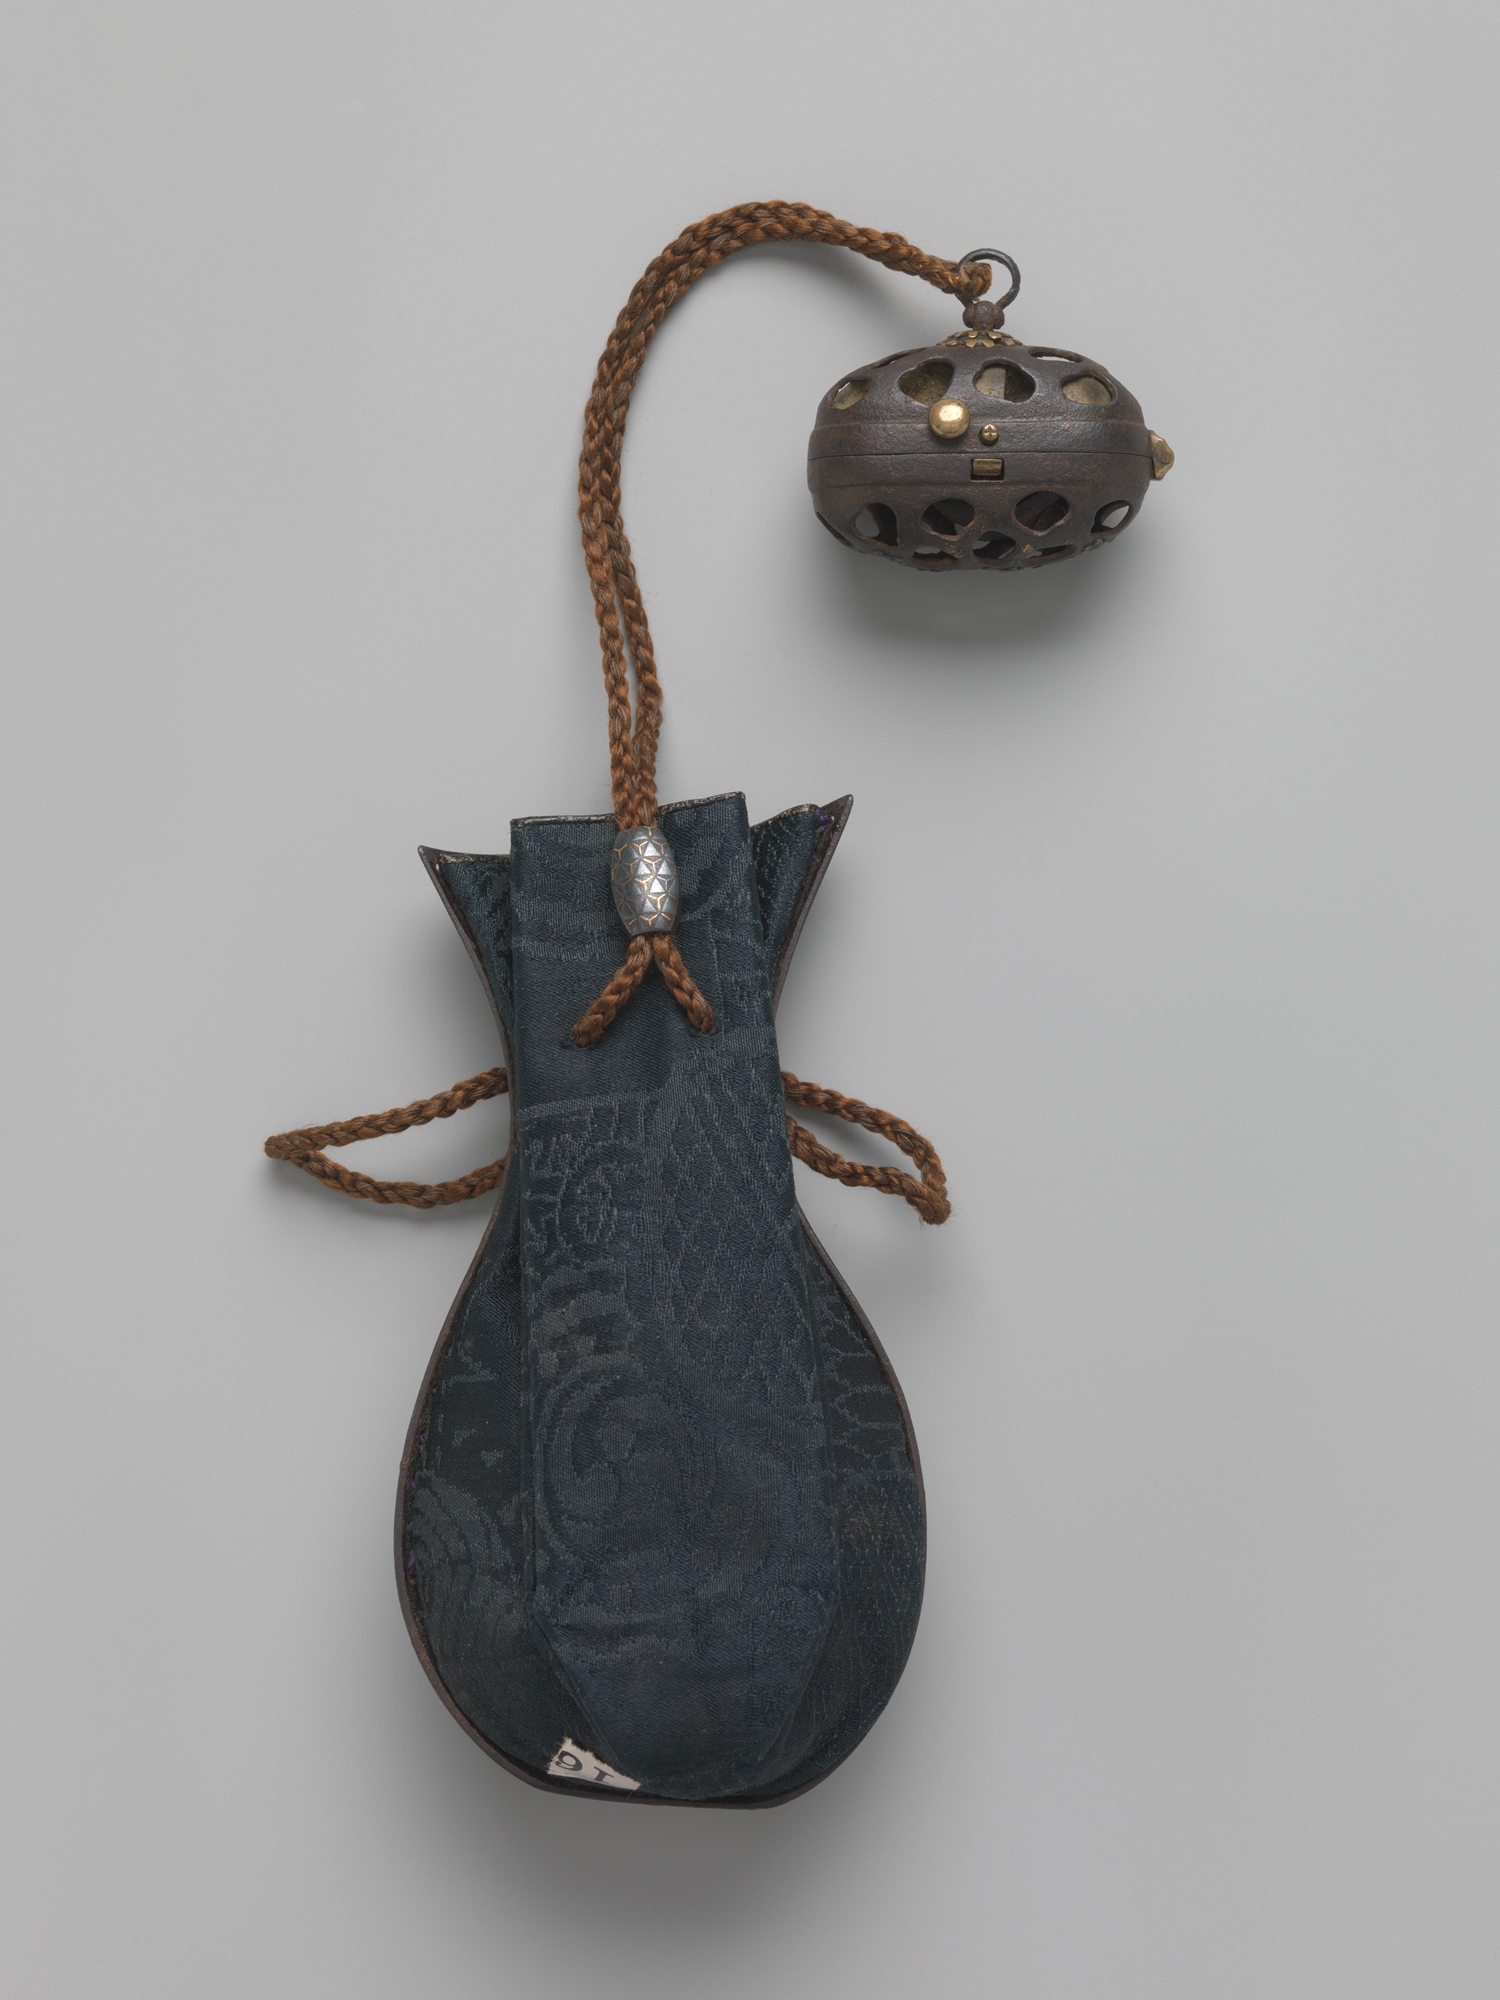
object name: tobacco pouch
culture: japanese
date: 1701-1800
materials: iron